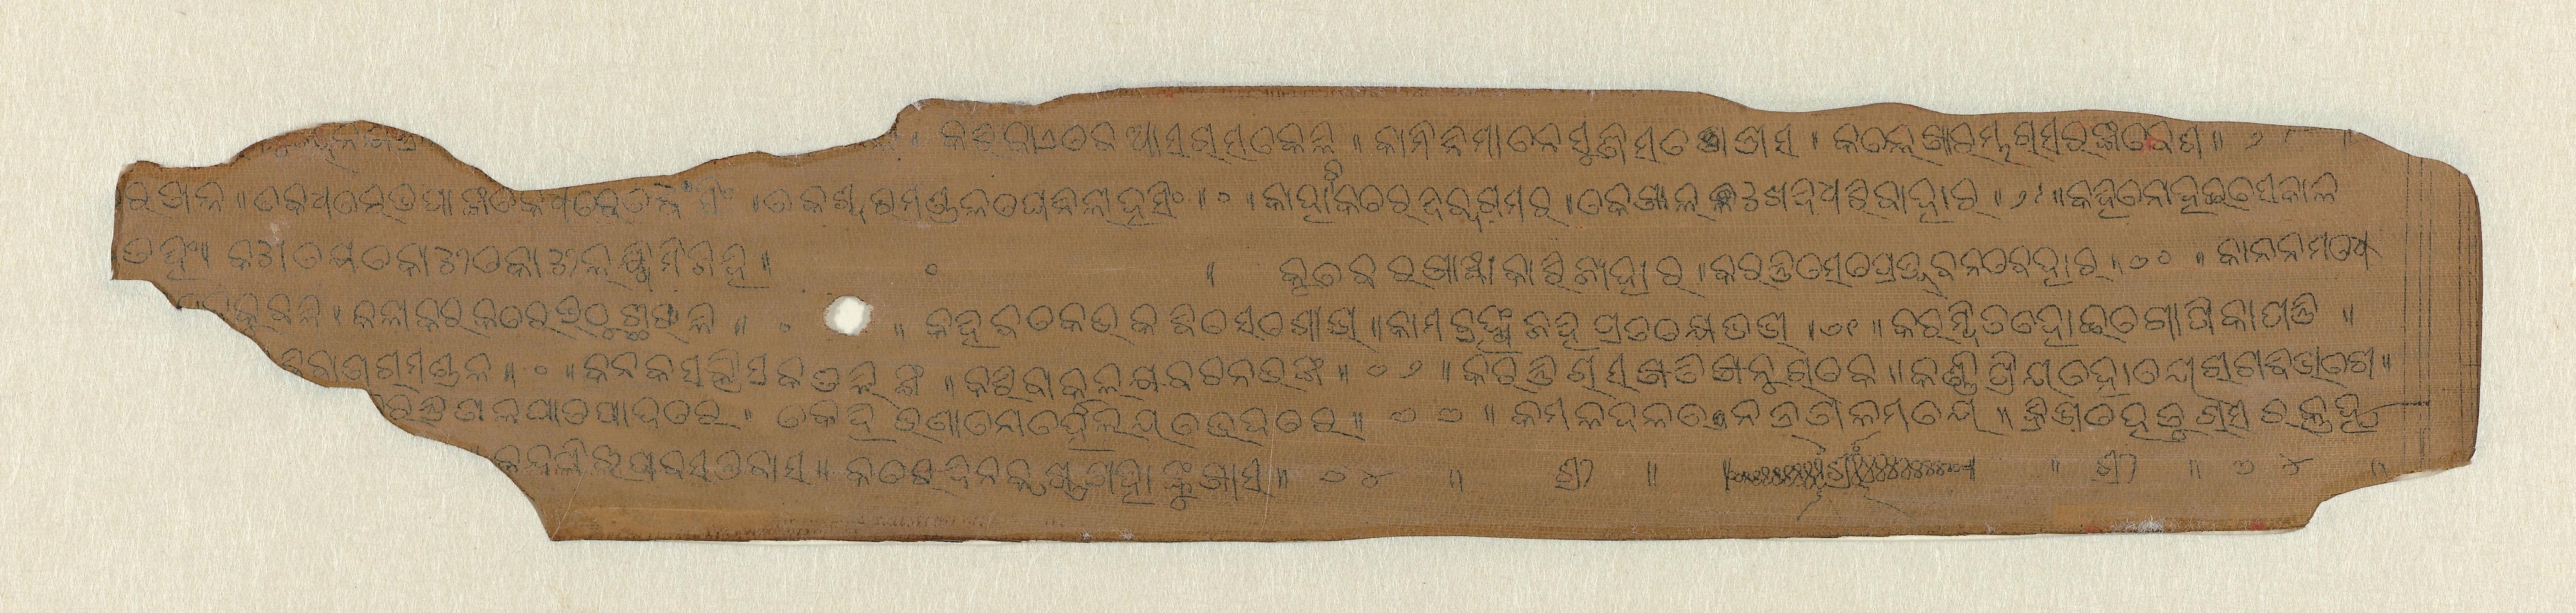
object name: indian miniature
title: Inscriptie in oud-Indiaas schrift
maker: Anonymous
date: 1800-1900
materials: cardboard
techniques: brush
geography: odisha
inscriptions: inscription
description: Onregelmatig stuk karton met links ponsgaatje en aan de linkerkant uitlopend in een smallere punt.